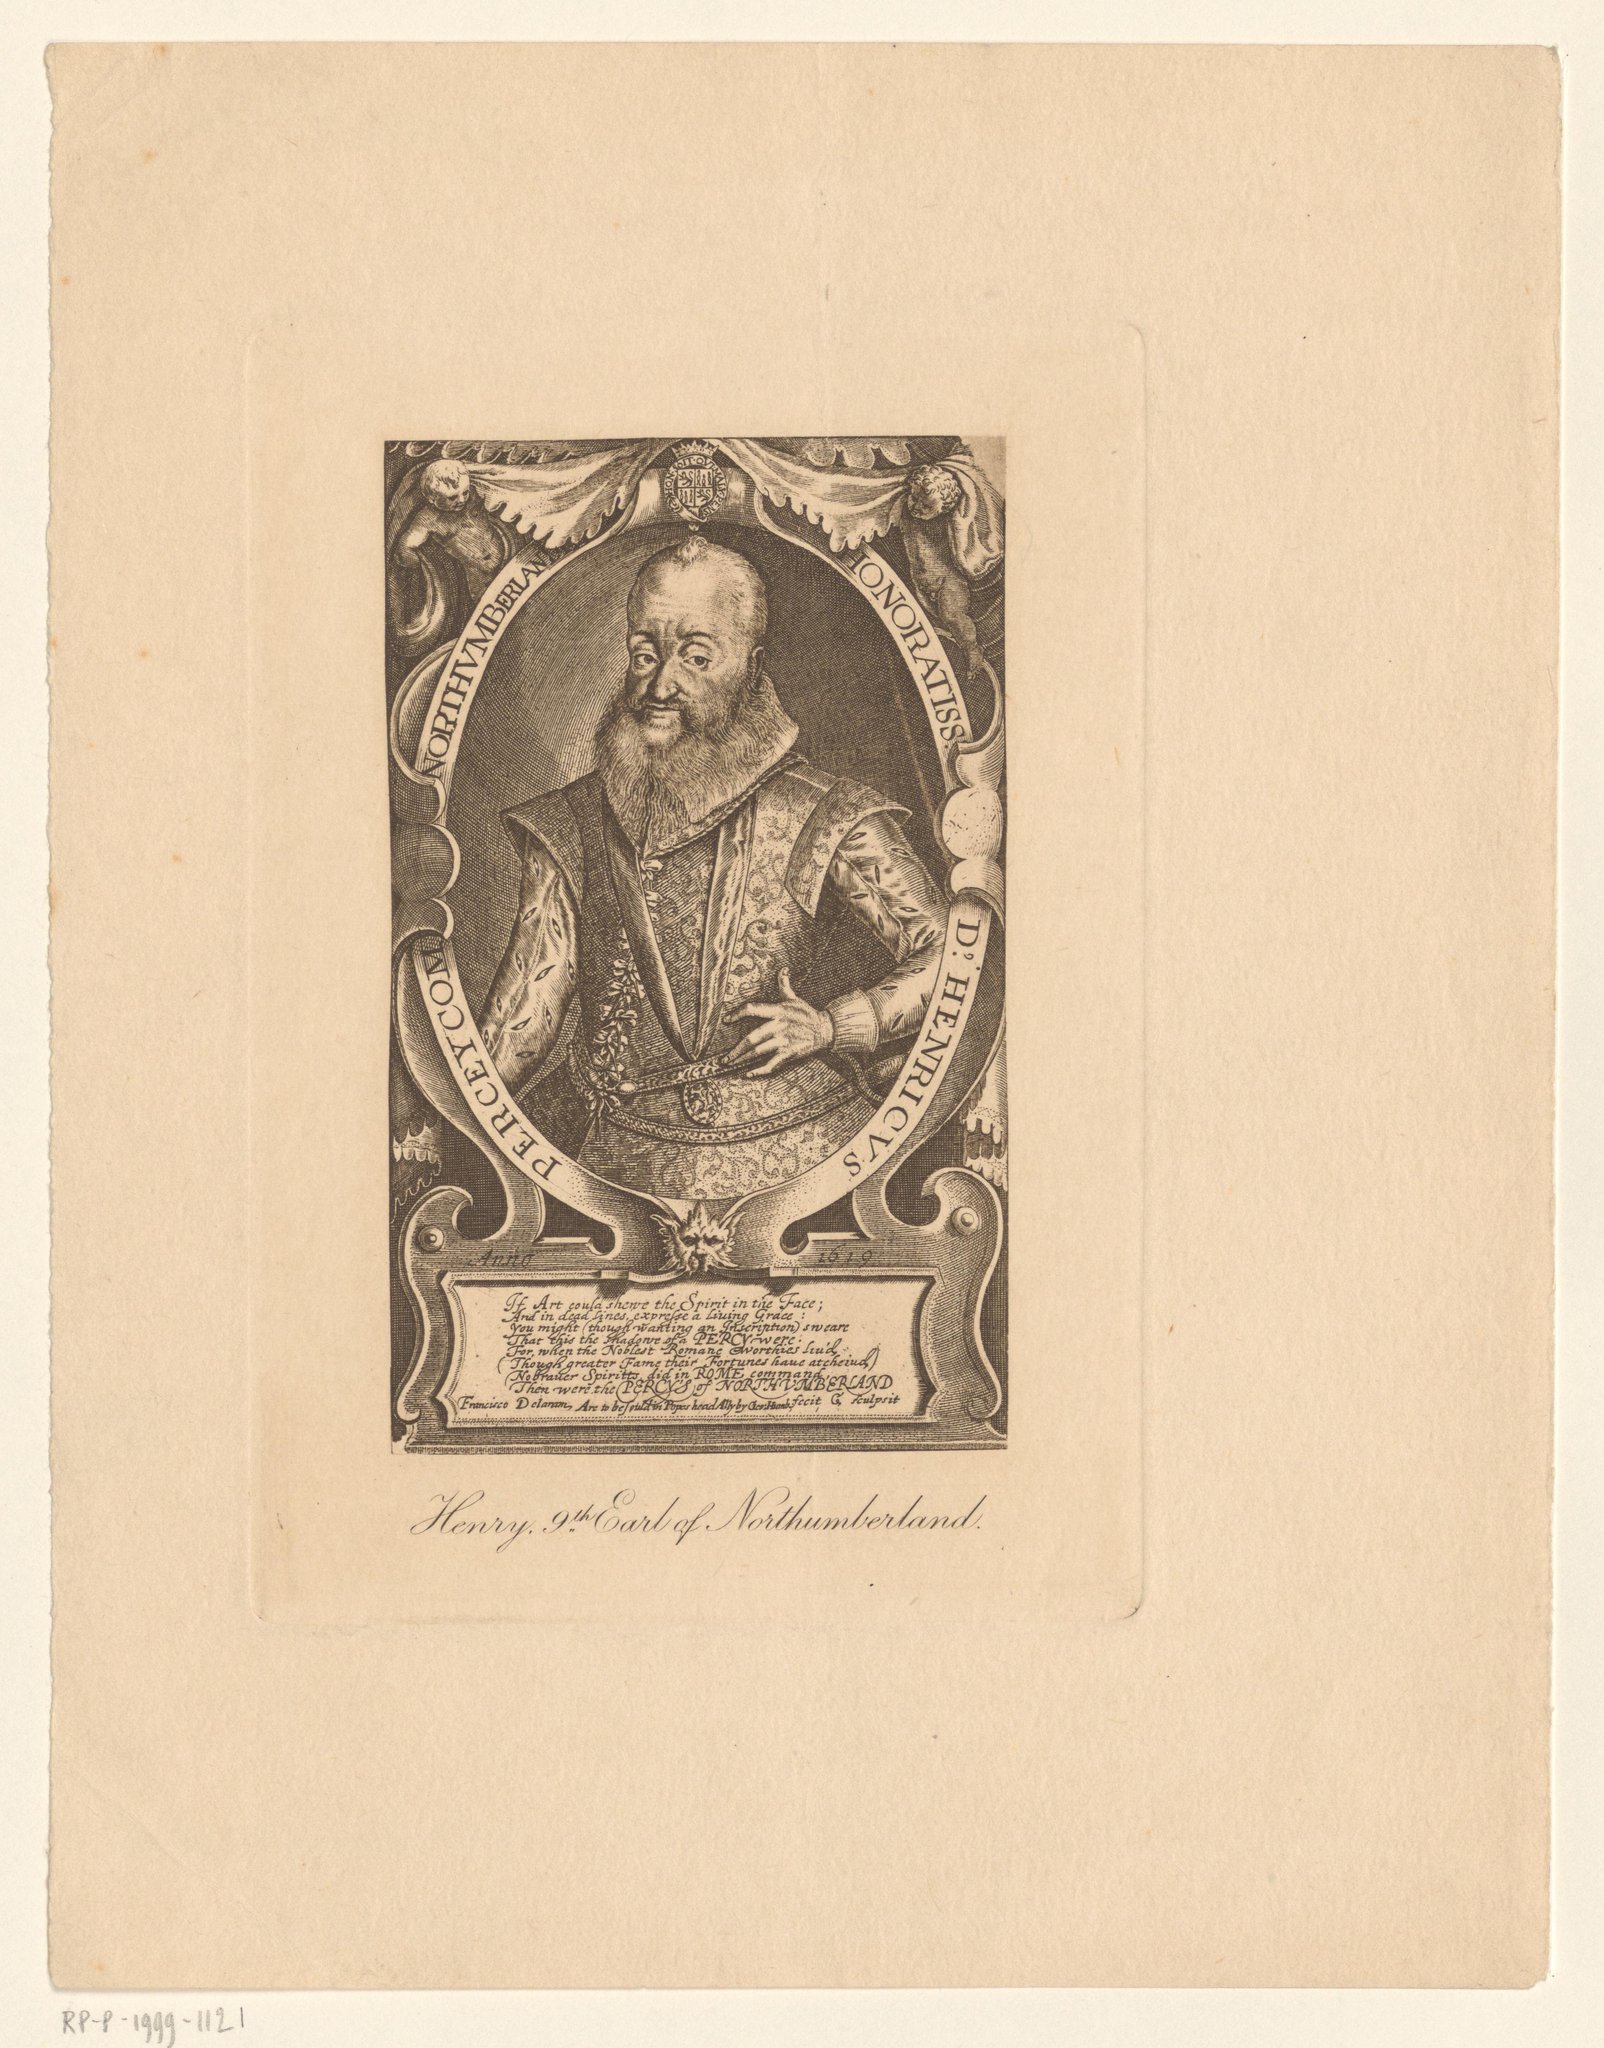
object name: photomechanical print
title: Portret van Henry Percy, 9e graaf van Northumberland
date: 1875-1930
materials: paper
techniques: photograph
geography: london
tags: earl, historical persons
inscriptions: collector's mark: Lugt 2228